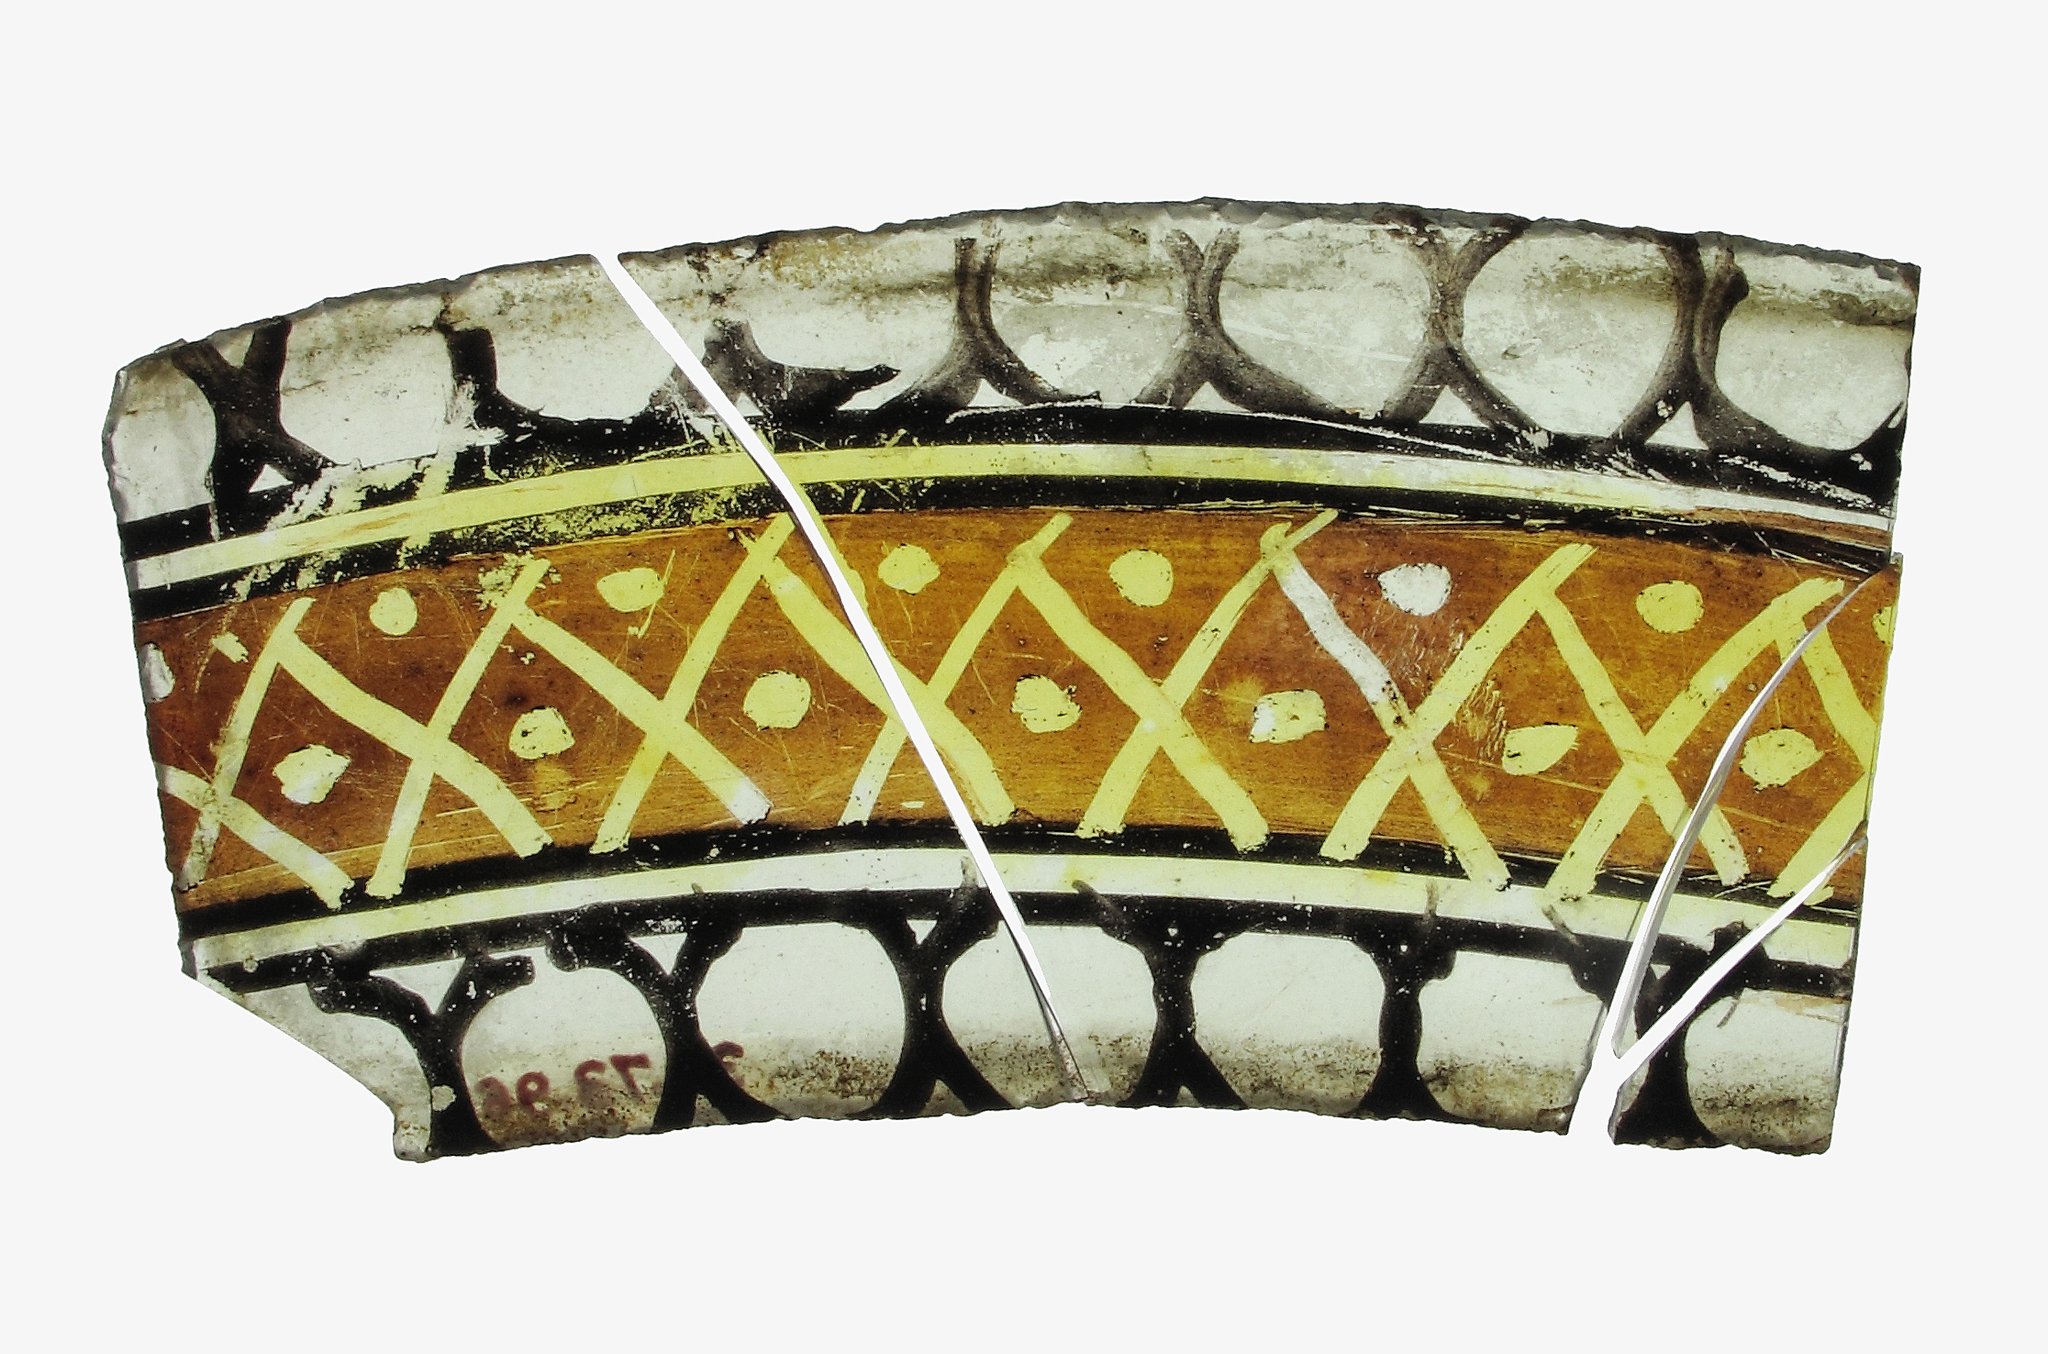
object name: fragment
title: Glass Fragment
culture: european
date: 1467-1600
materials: glass, pigment